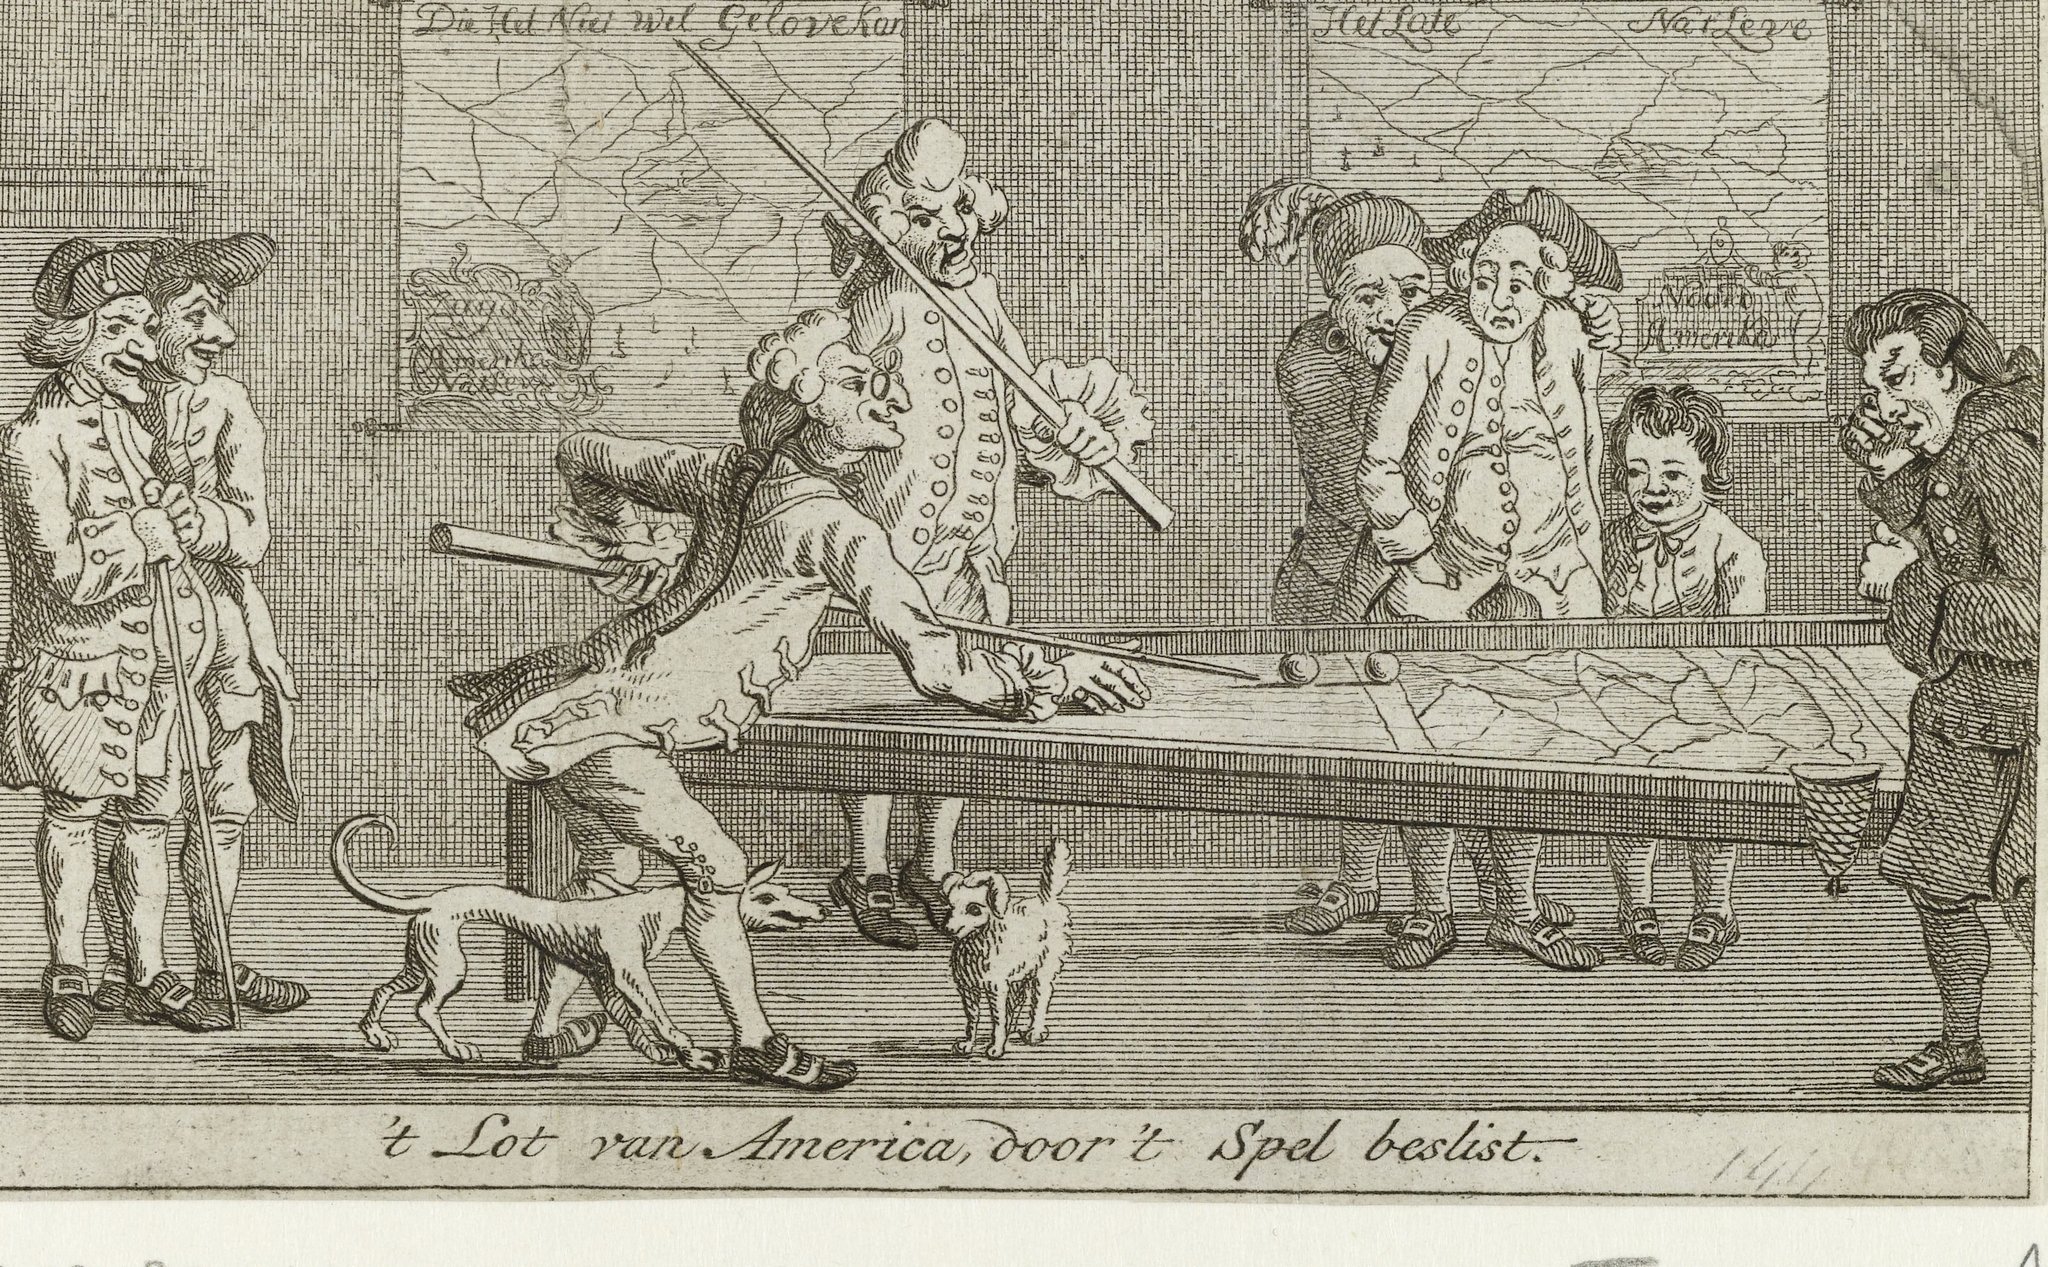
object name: print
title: 't Lot van America, door 't Spel beslist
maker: Anonymous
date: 1782-1783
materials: paper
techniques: engraving, etching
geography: northern netherlands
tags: billiards, political caricatures and satires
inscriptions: collector's mark: Lugt 2228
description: Spotprent waarin het lot van de Verenigde Staten wordt beslist door een biljartspel tussen twee mannen (Europese vorsten), ca. 1782. Aan de wand kaarten van Noord- en Zuid-Amerika.